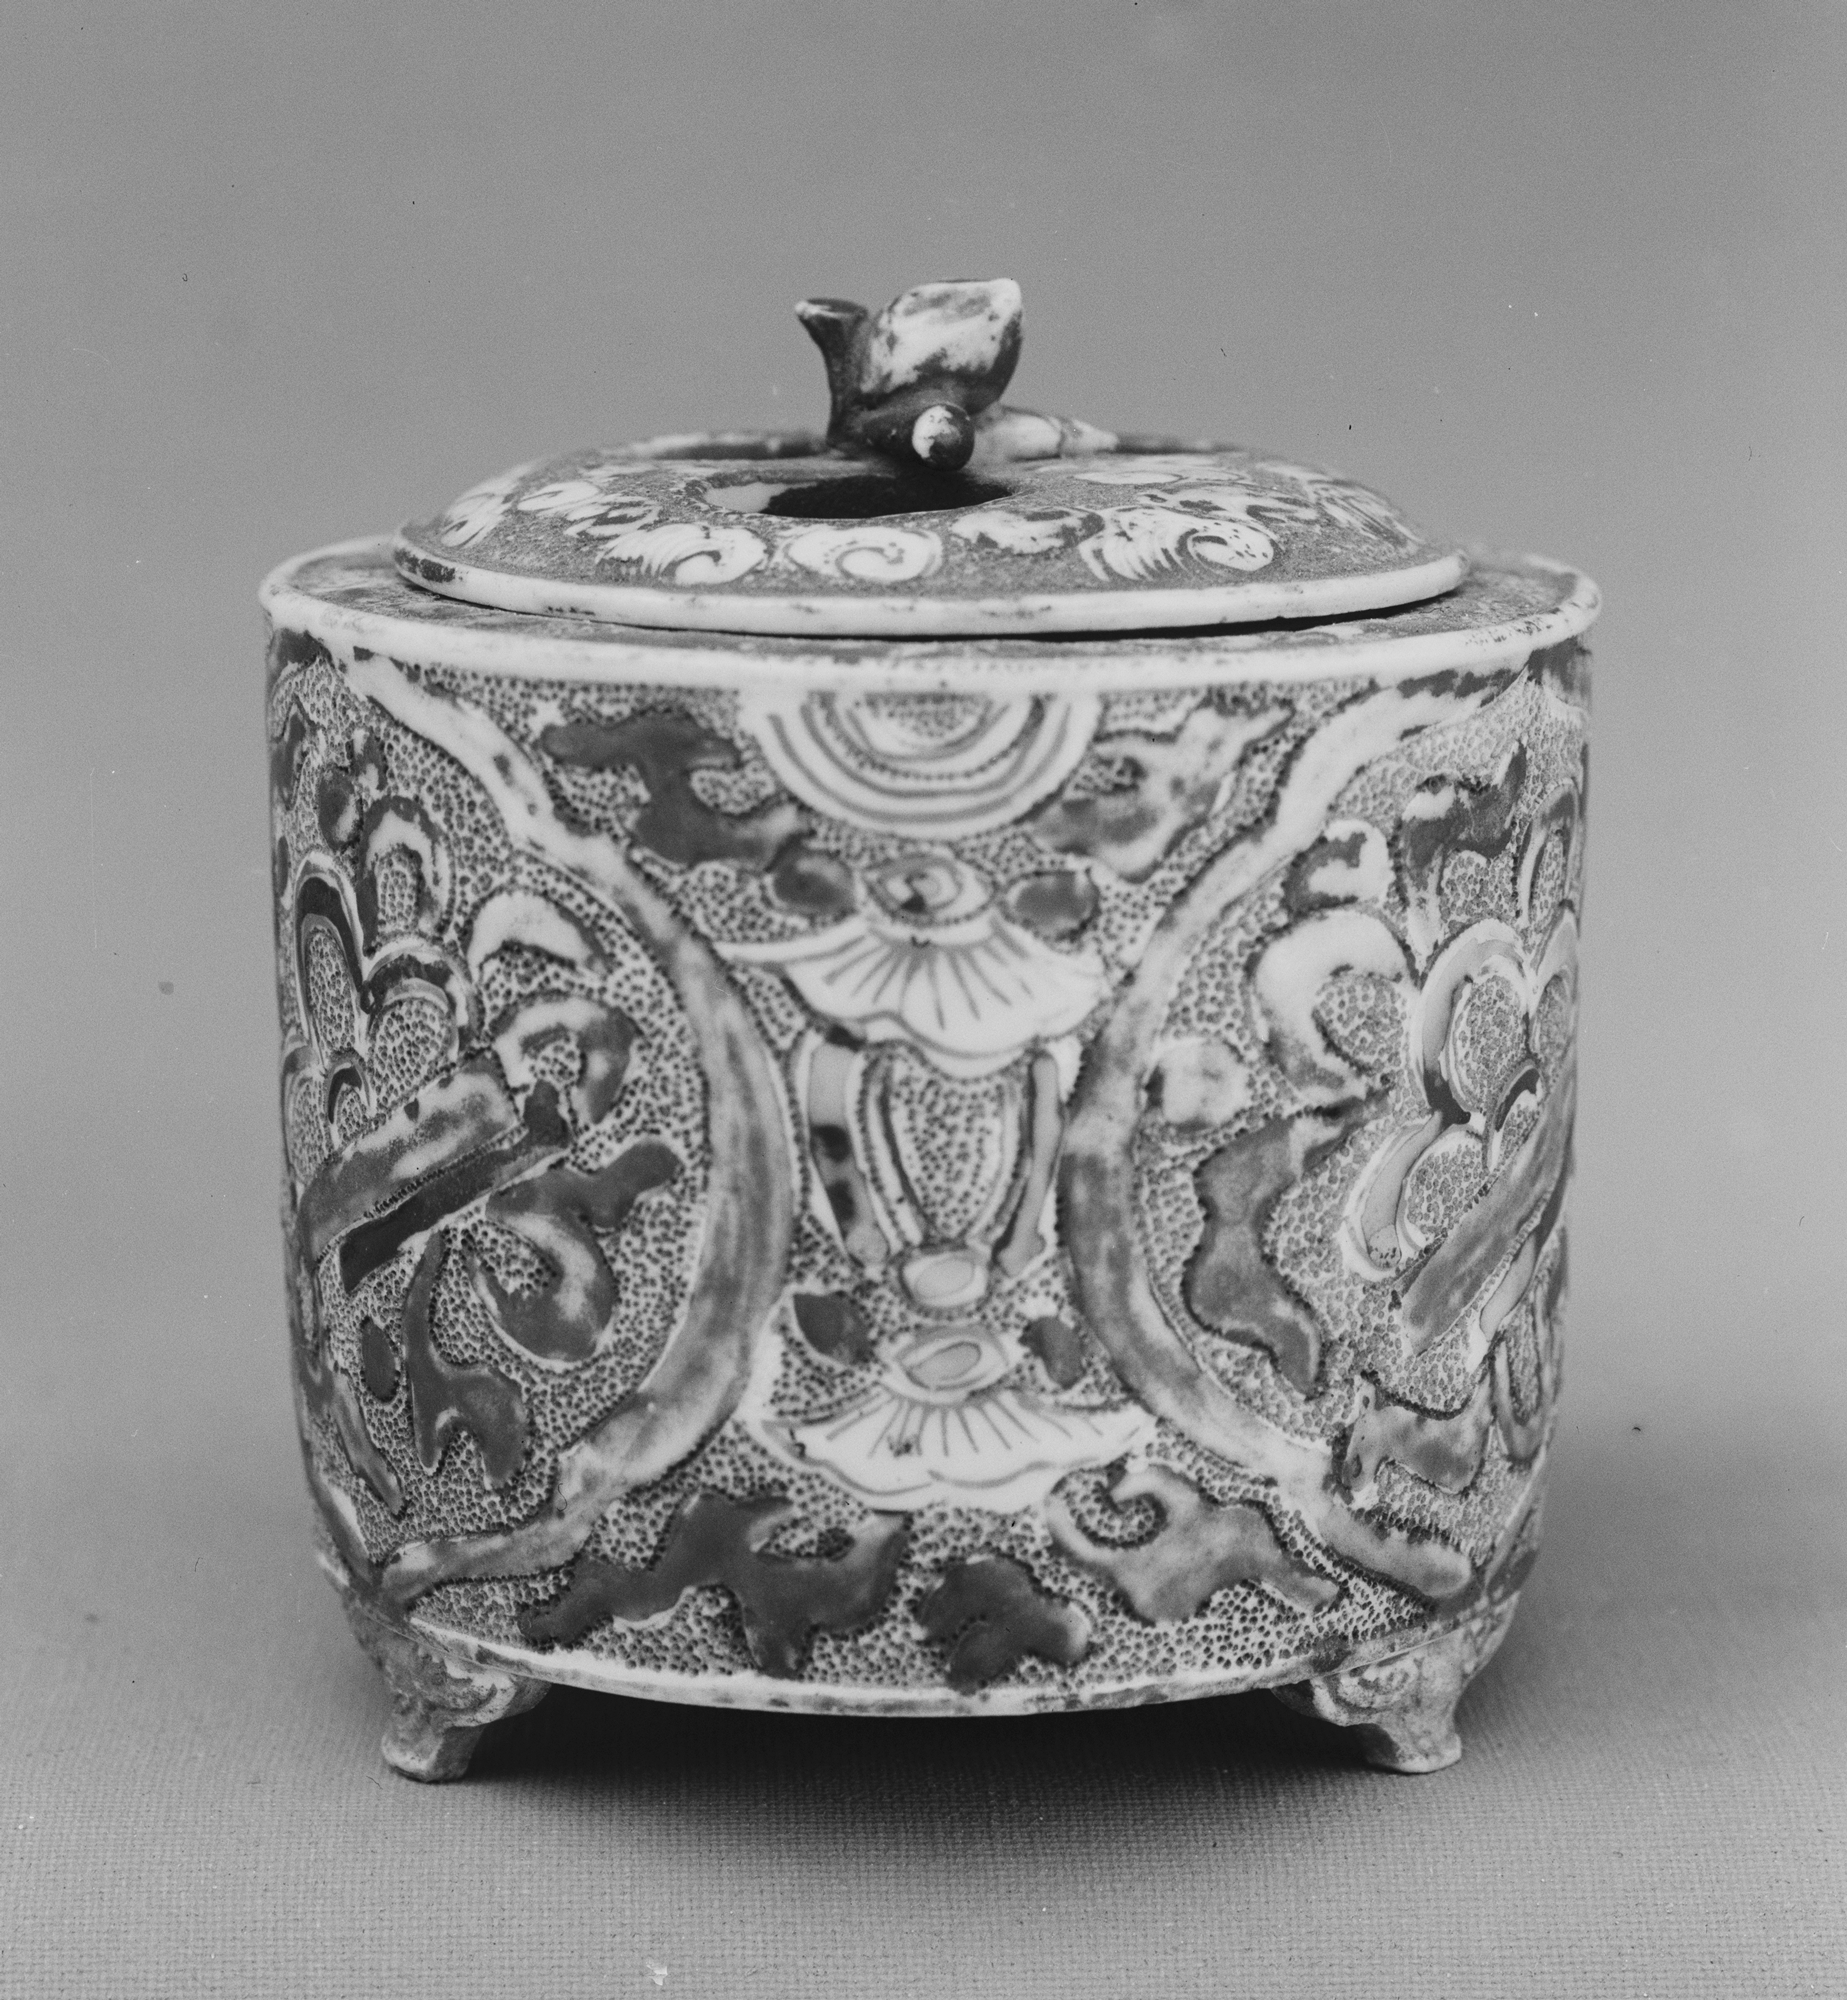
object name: incense burner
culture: japanese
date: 1700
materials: gold, iron, porcelain, silver